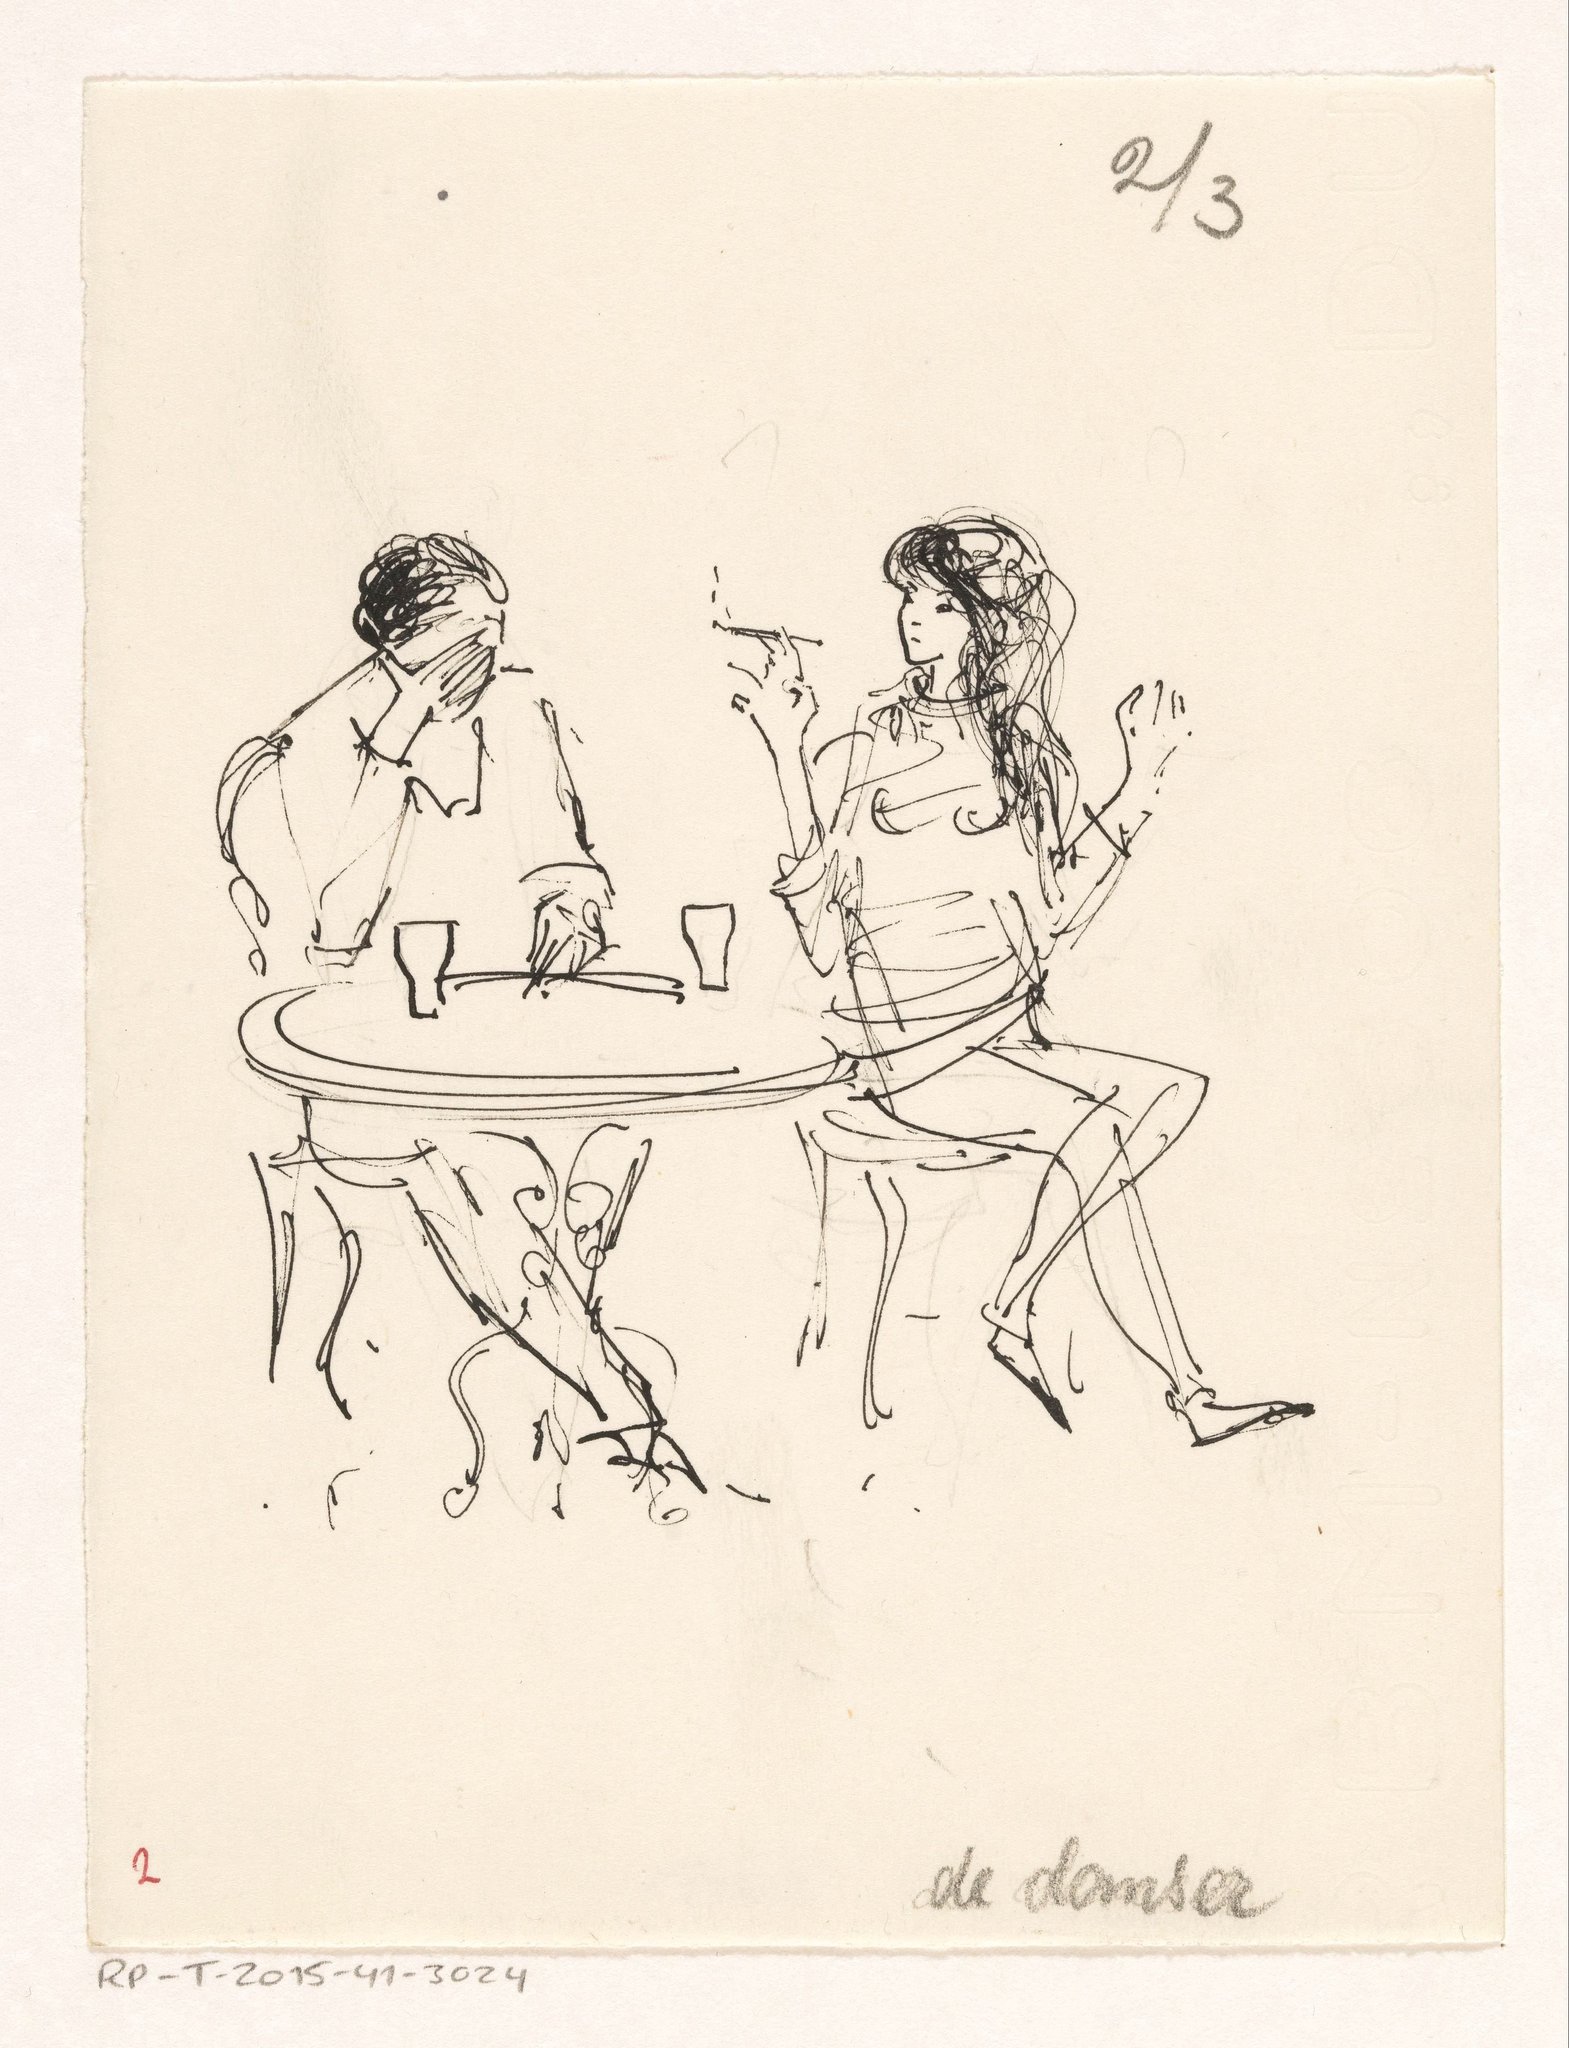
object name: boekillustratie ontwerp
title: Man en vrouw op een terras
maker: Anonymous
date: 1930-1970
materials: ink, paper, pencil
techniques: pen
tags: cigarette, pavement, terrace in front of inn or restaurant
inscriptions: number: ‘2’, annotation: ‘de danser’, collector's mark: Lugt 2228a, factory mark: ‘R BM - No 606 ,, DU’, :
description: Een man en vrouw zitten op een terras. Op tafel staan twee bierglazen. De man houdt zijn hand voor zijn gezicht en de vrouw rookt een sigaret. De vrouw lijkt om haar as te draaien.